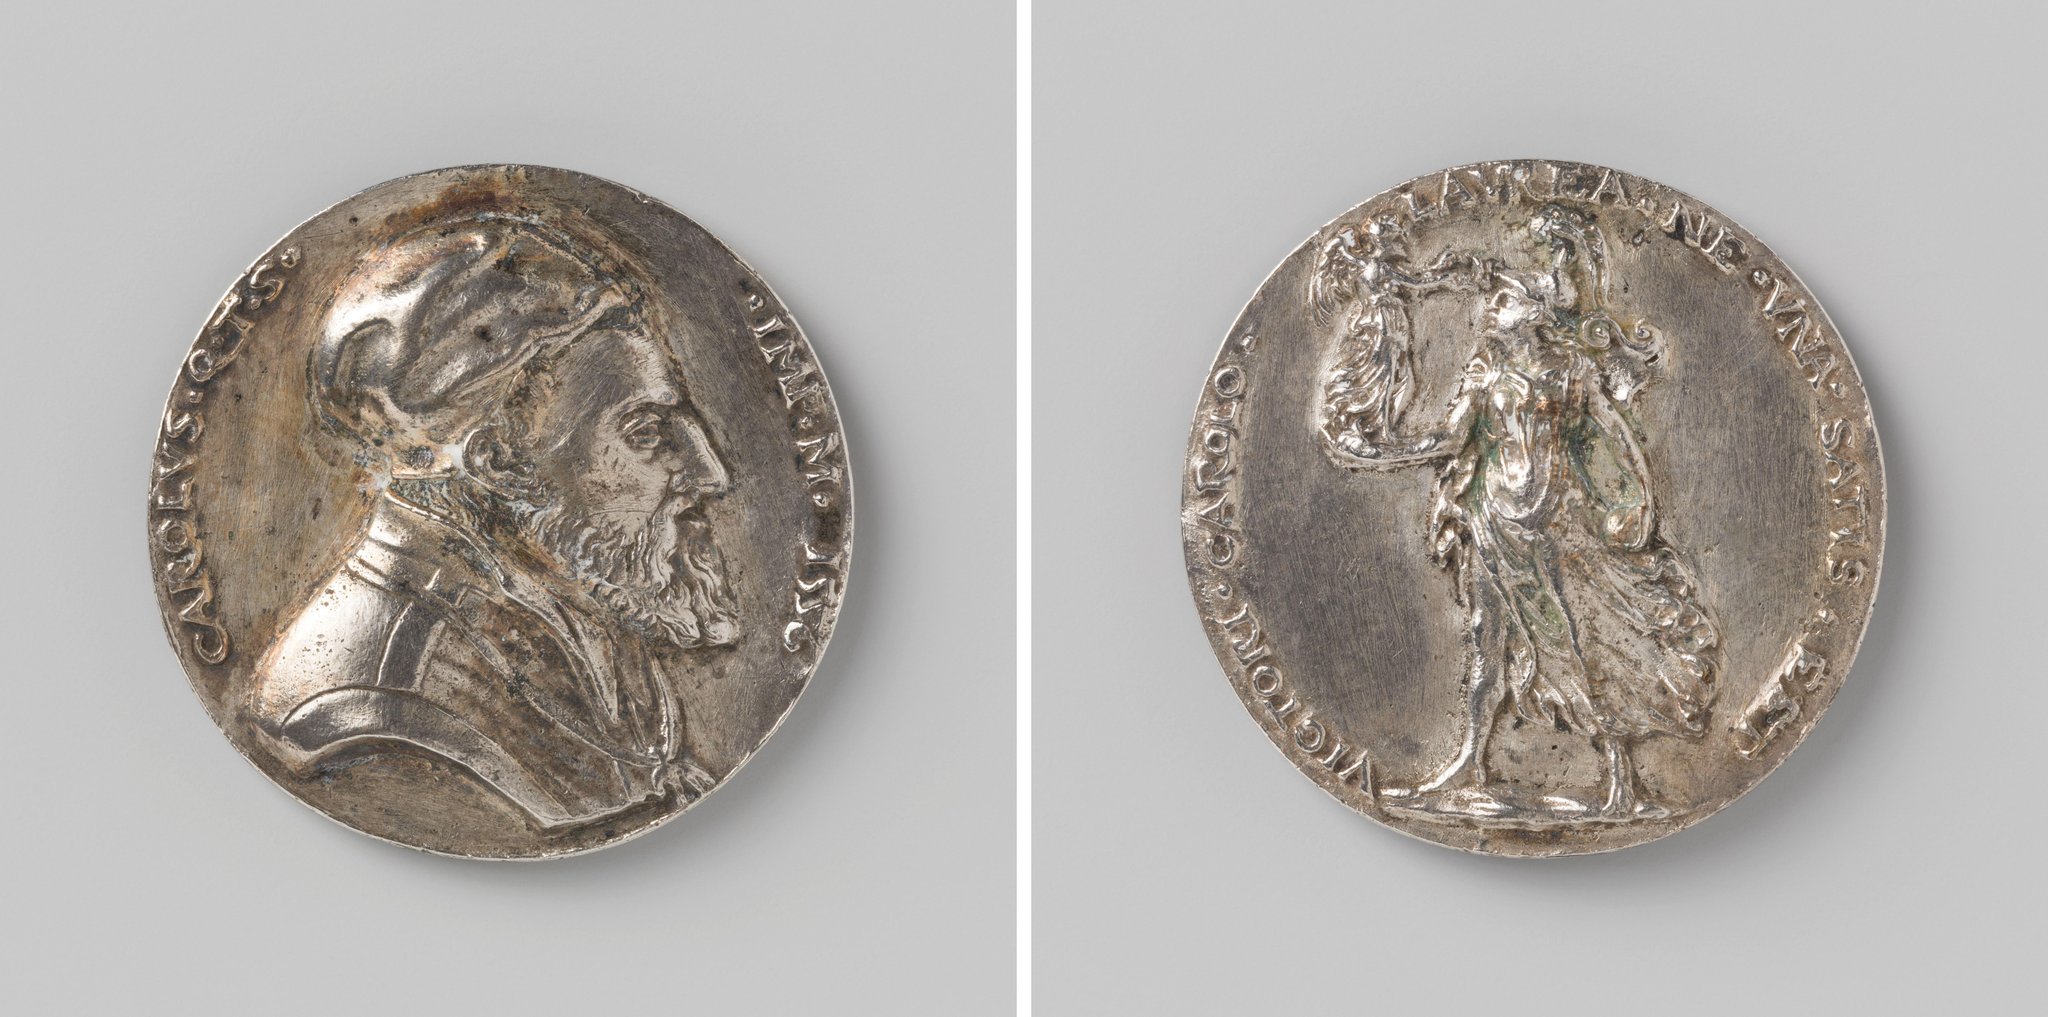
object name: history medal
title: Karel V, Duits keizer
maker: Anonymous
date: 1556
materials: silver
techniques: casting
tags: charles v (holy roman emperor and king of spain)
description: Zilveren penning. Voorzijde: borststuk man binnen omschrift. Keerzijde: gehelmde vrouw houdt Overwinning in haar hand, die haar een lauwerkrans boven hoofd houdt binnen omschrift